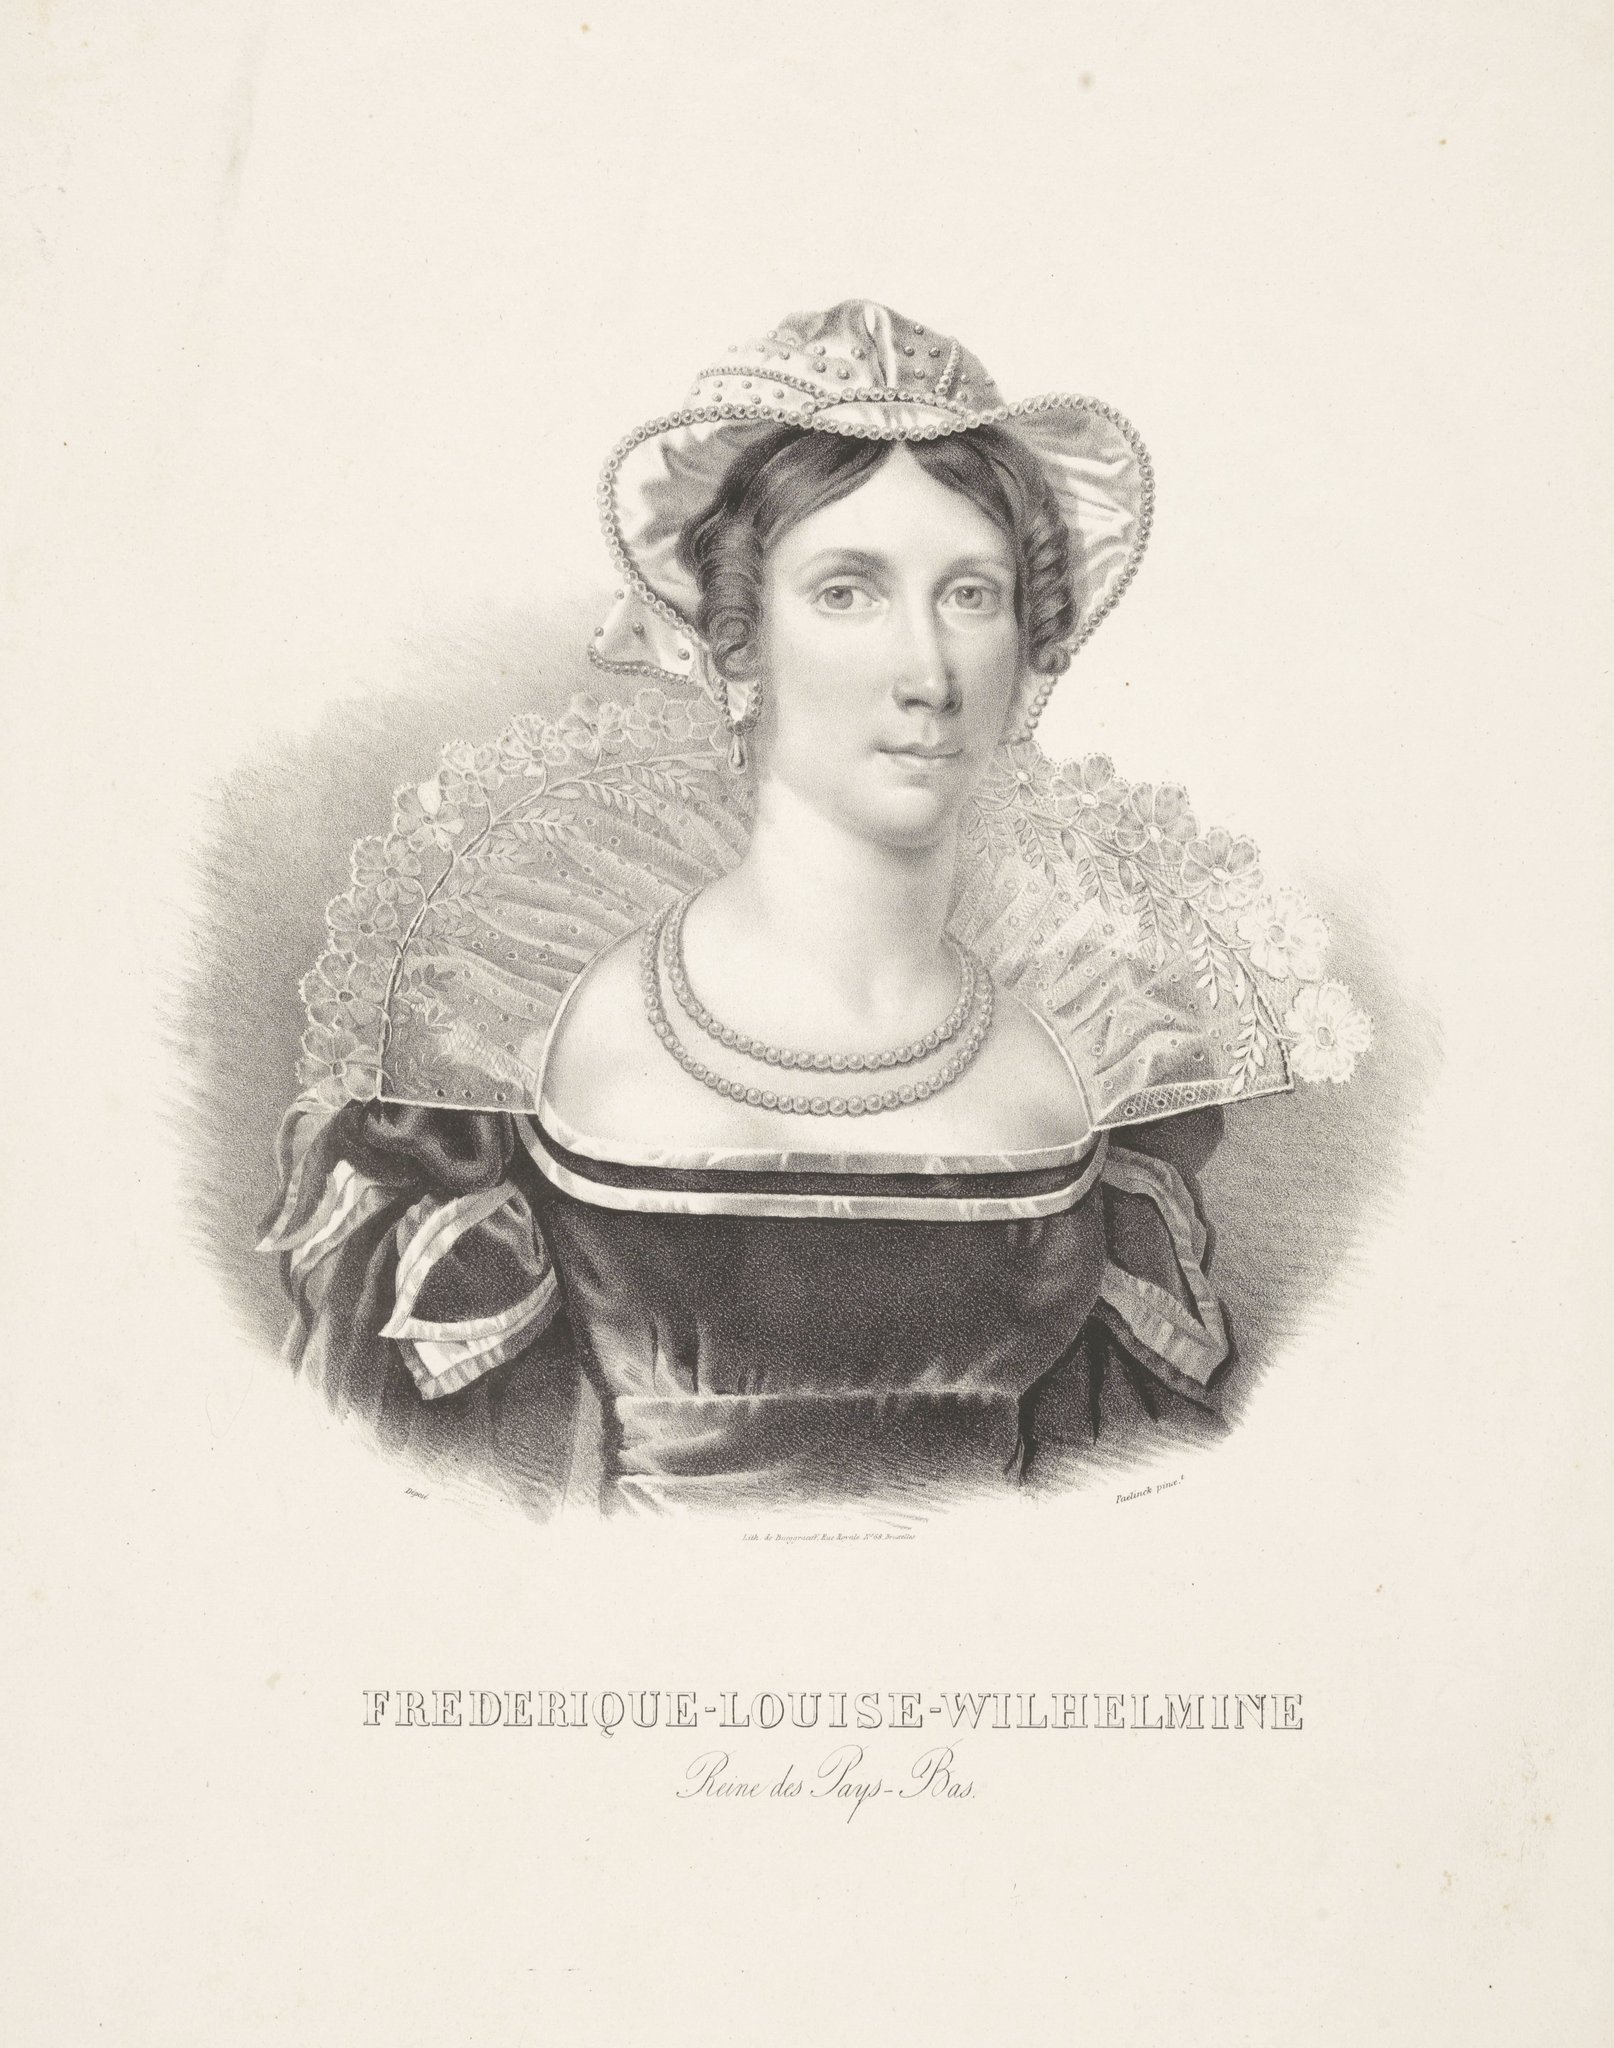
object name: print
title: Portret van Wilhelmina van Pruisen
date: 1826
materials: paper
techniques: lithograph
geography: brussels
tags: berlin, the hague, wilhelmina frederica louisa (koningin der nederlanden)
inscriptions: octrooivermelding, gedrukt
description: Portret van Wilhelmina. In de ondermarge haar naam en titel.